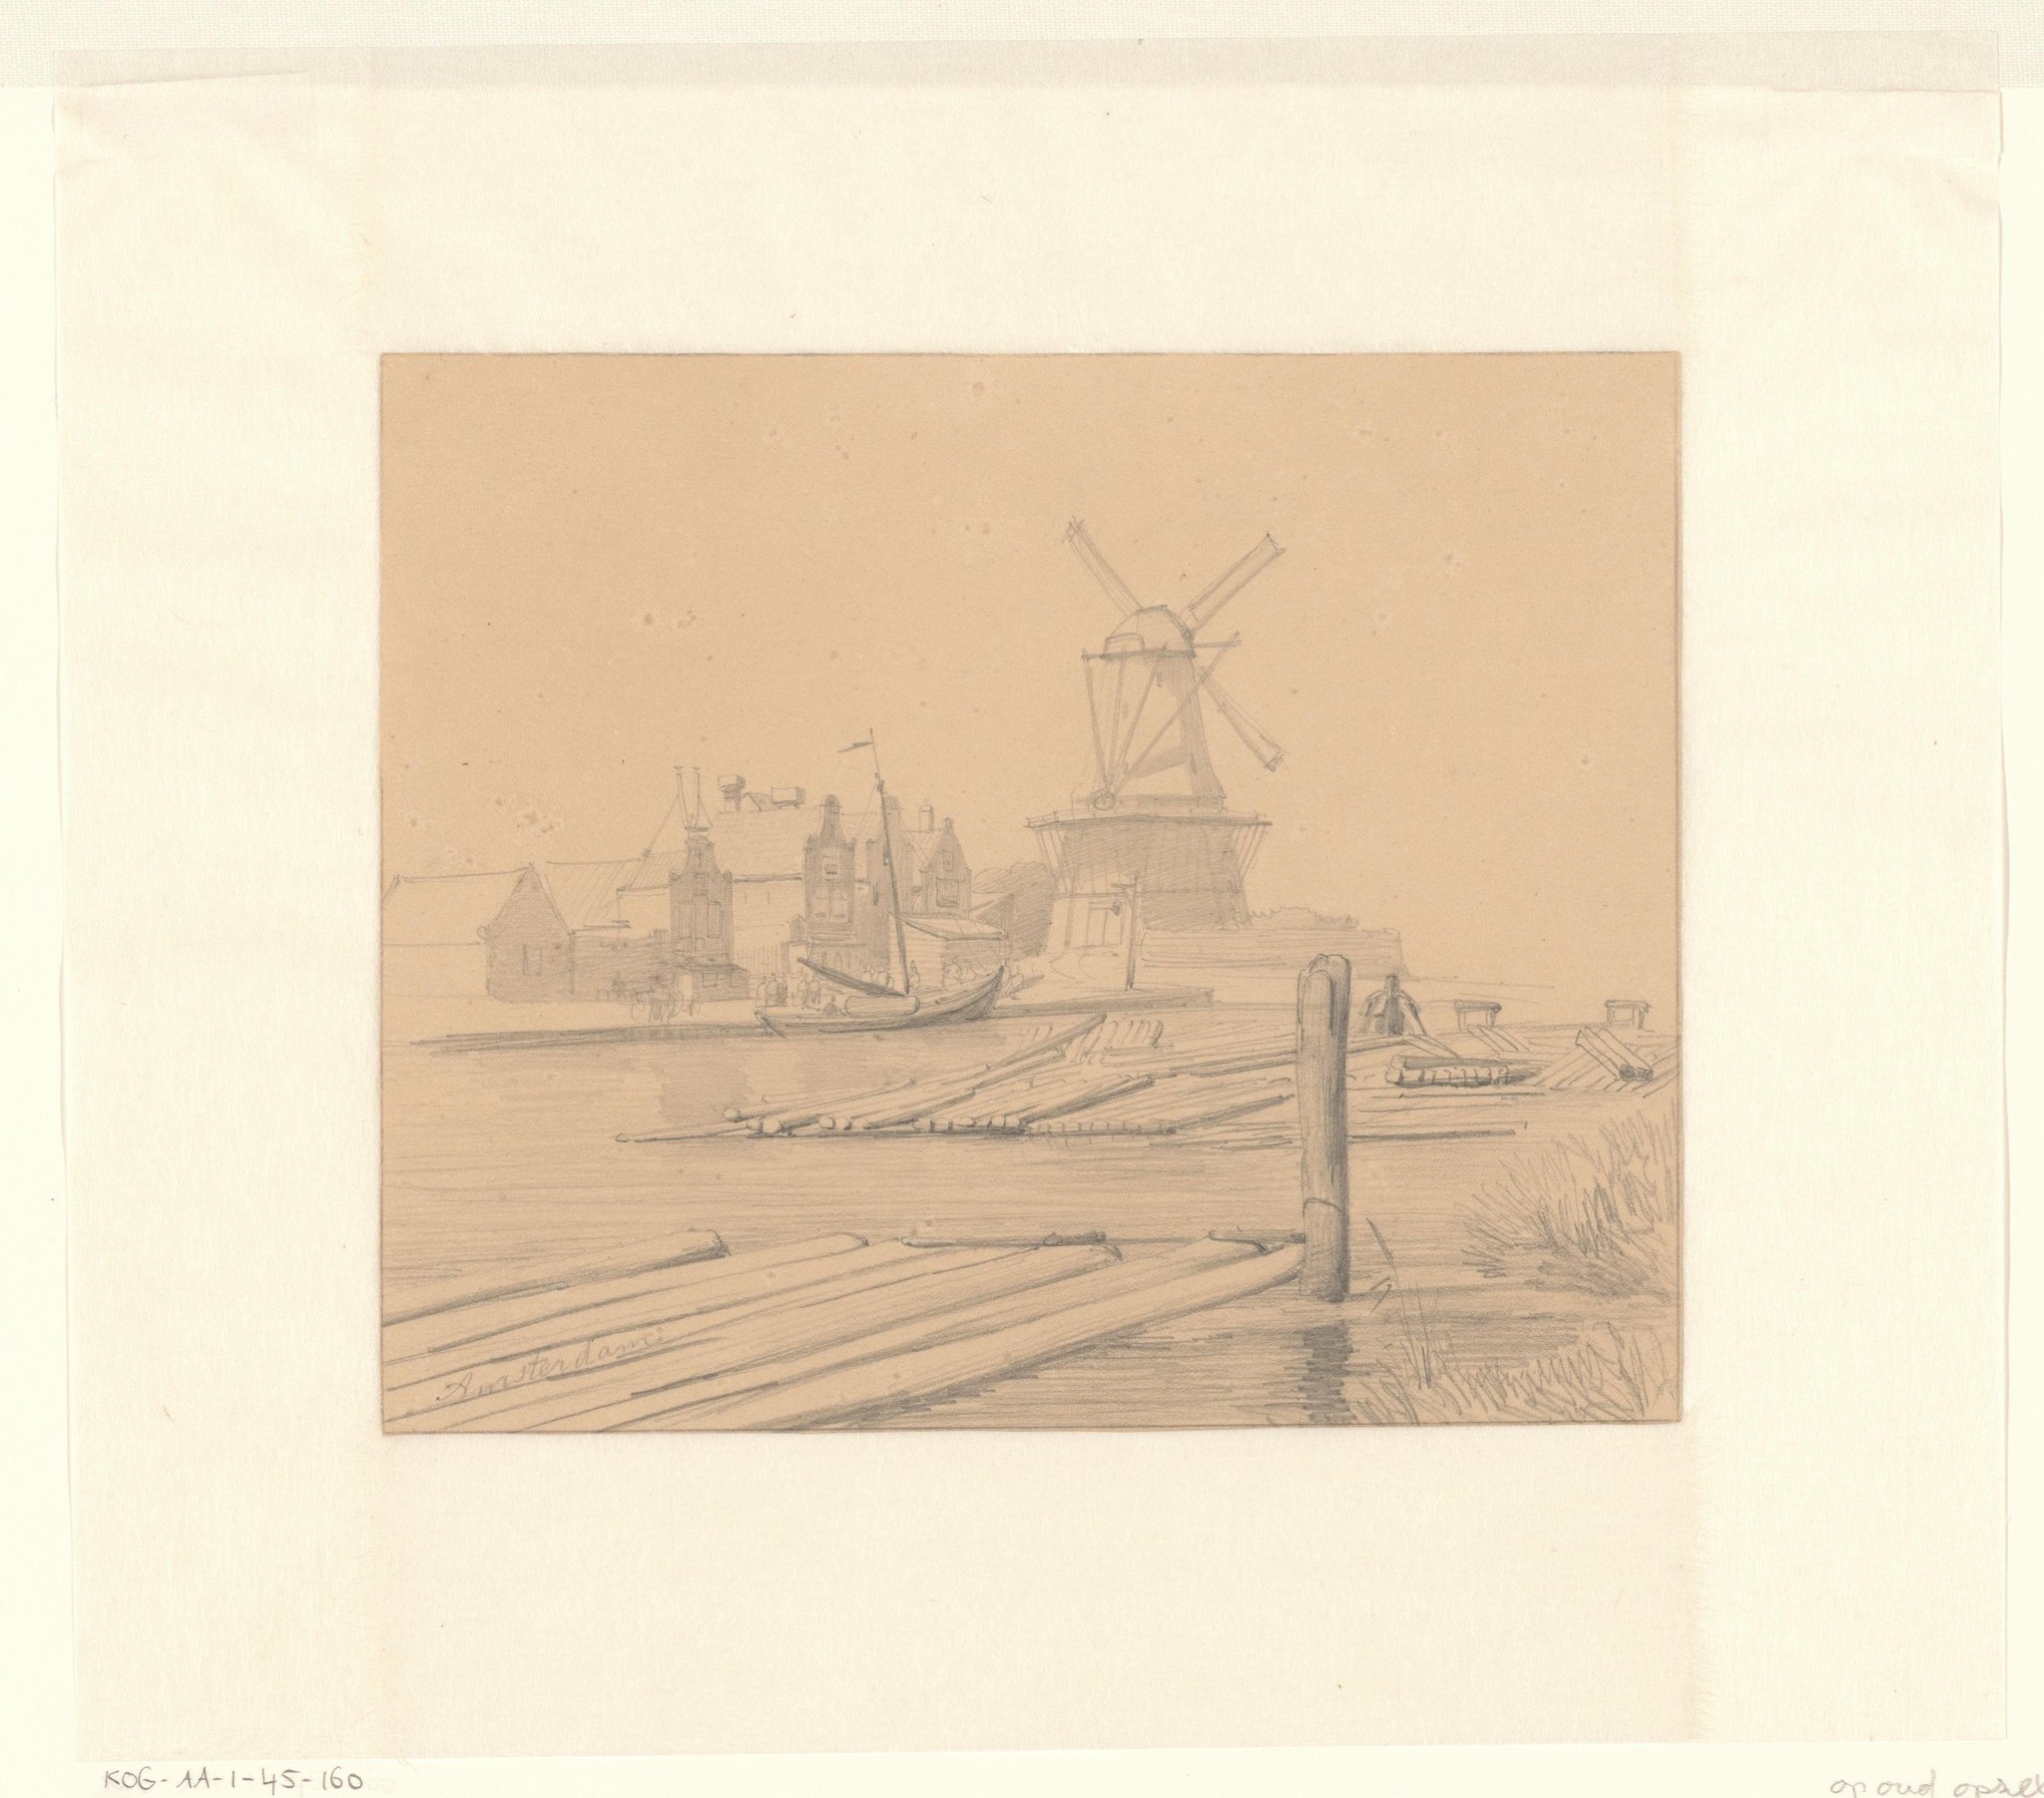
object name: drawing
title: Gezicht op molen De Bok op bolwerk Het Blauwhoofd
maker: Anonymous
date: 1800-1879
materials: paper, pencil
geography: amsterdam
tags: city-view in general; 'veduta', windmill in landscape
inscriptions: inscription: ‘Port 45 N-160 / W36 no 1002 / molen De Bok / op oud opzetvel doorgehaald / stempel "Atlas Amsterdam / J. van Eck"’, inscription: ‘Amsterdam’, collector's mark: Lugt 800a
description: Onderwerpsrubriek binnen de Atlas Amsterdam: Molens.